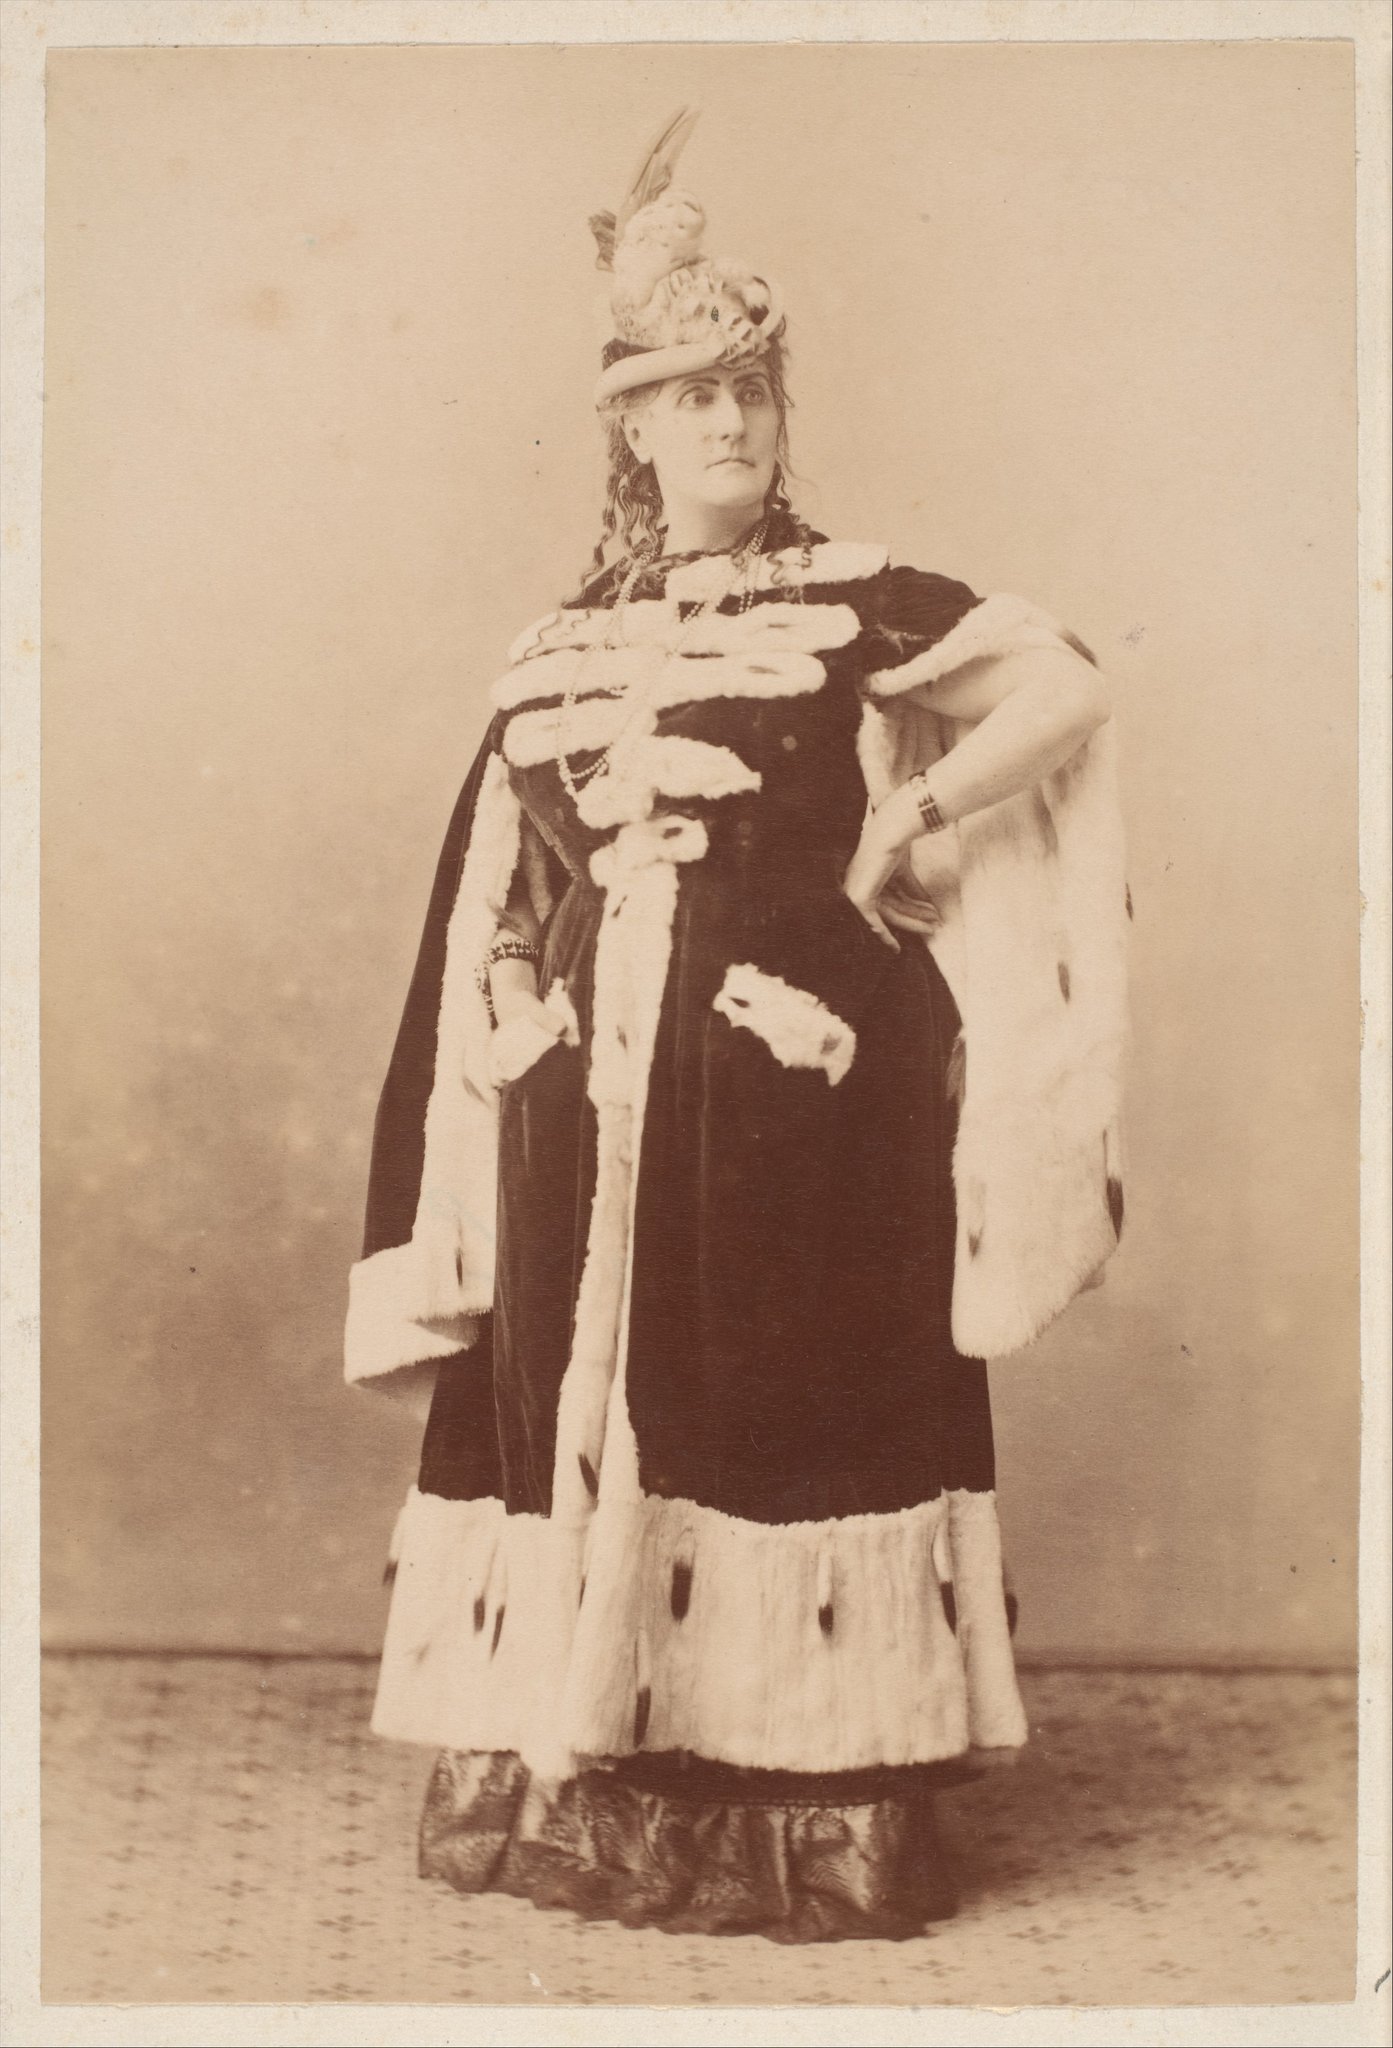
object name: photograph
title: [La Comtesse in Ermine Cape]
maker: pierre-louis pierson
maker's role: artist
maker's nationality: french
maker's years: 1822-1913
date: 1860-1869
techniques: albumen silver print, glass negative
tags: portraits,women